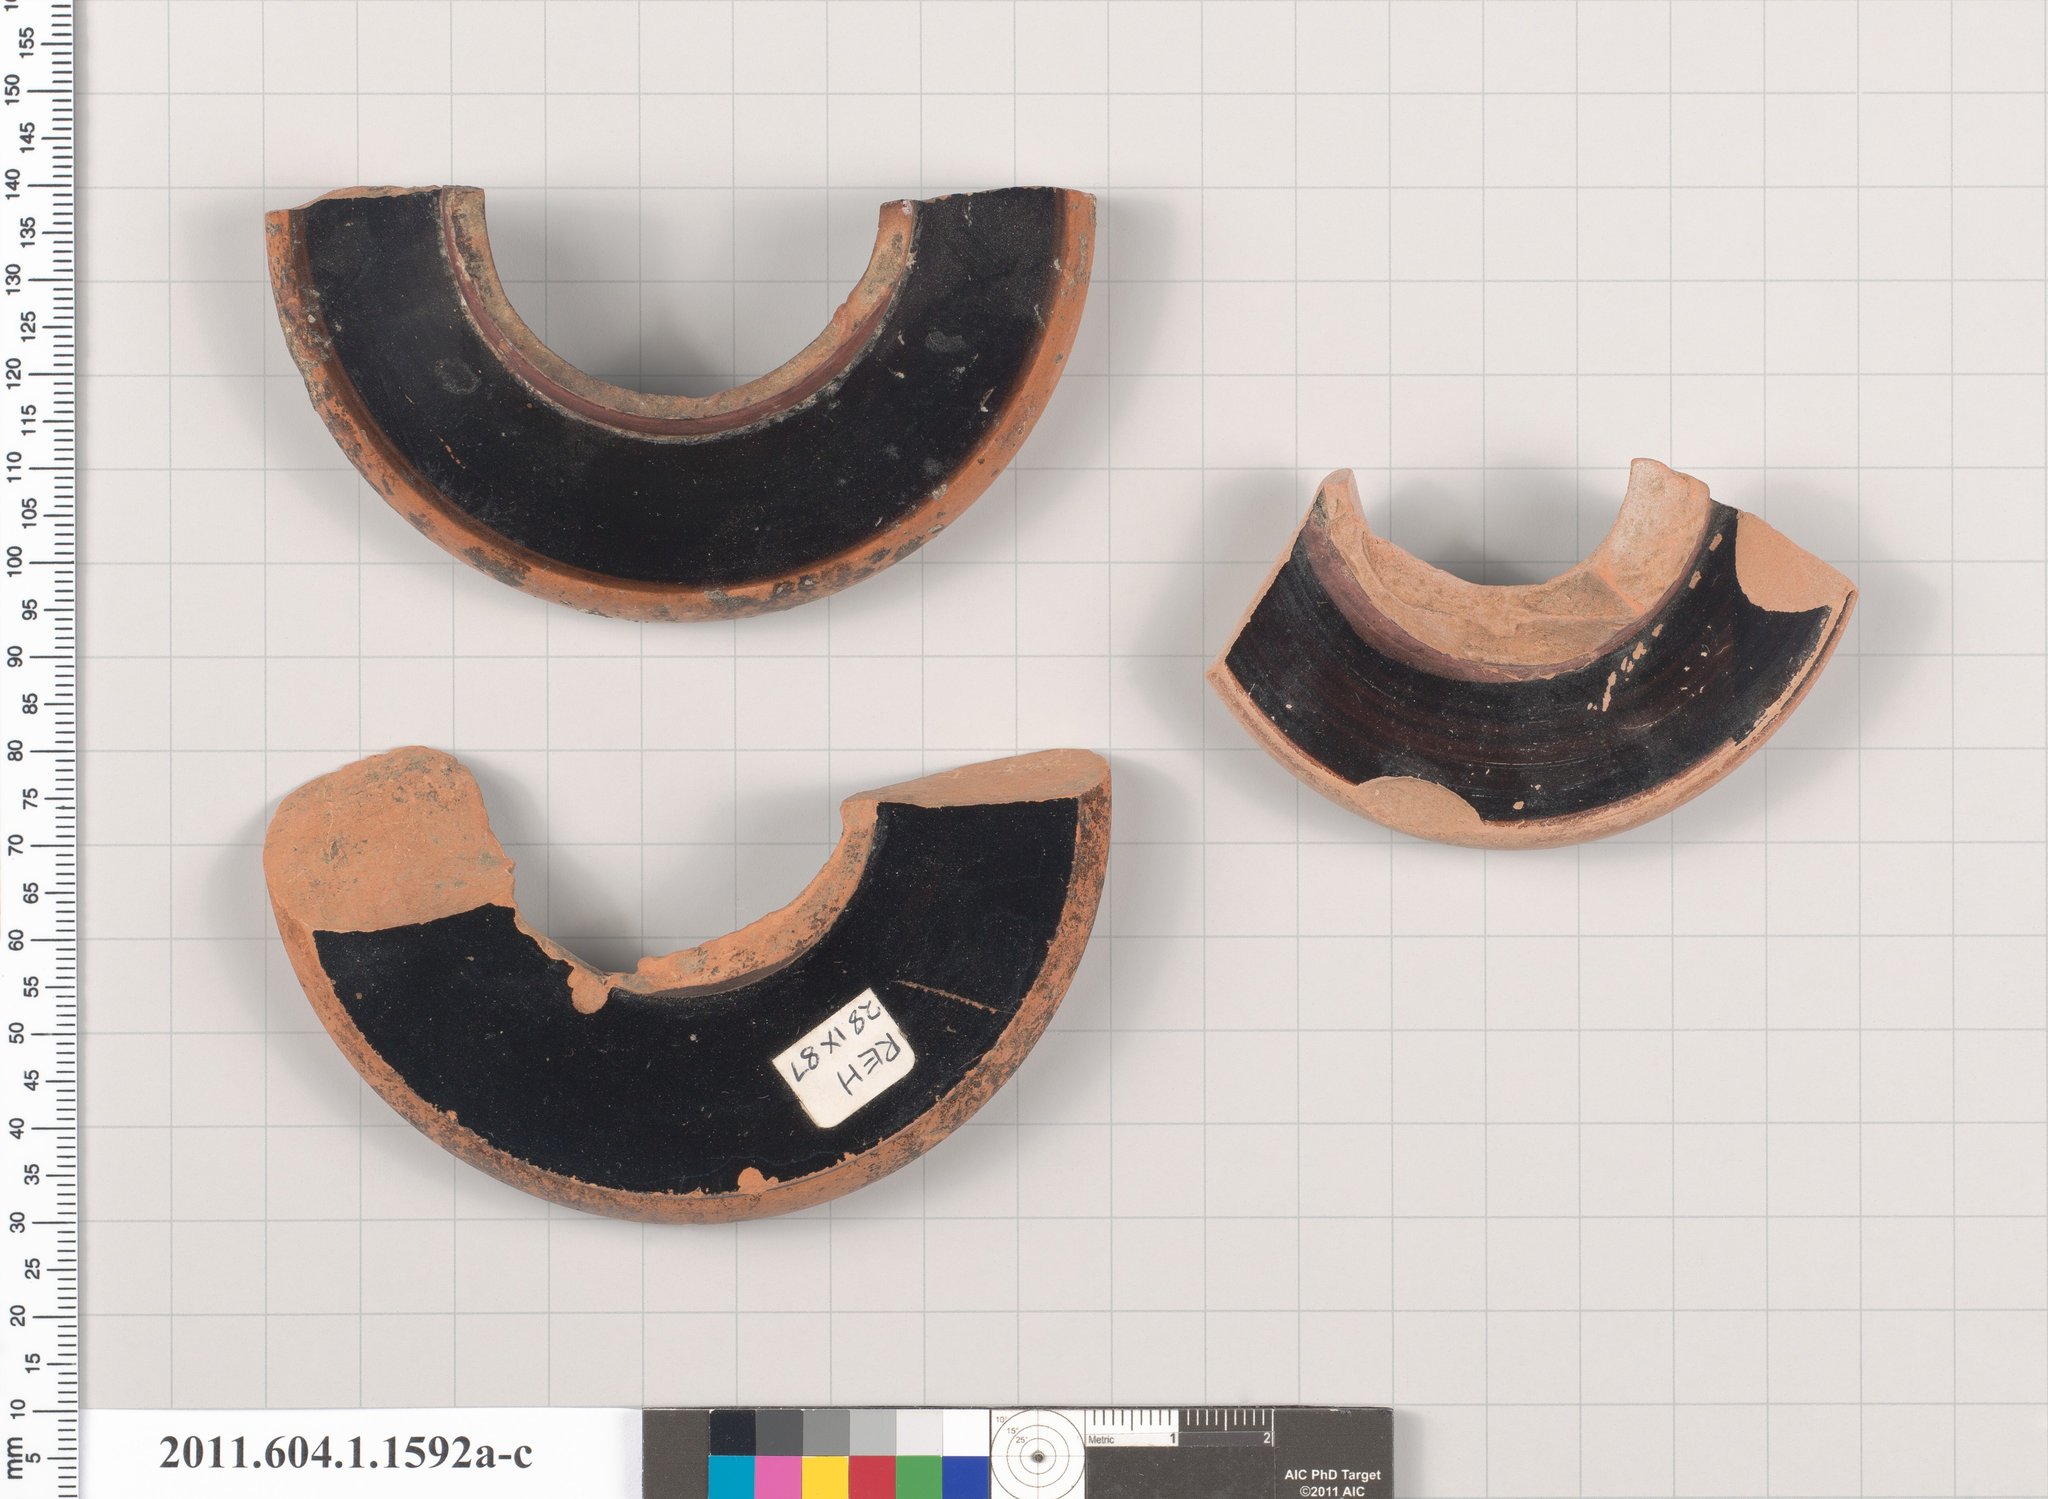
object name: kylix fragment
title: Terracotta fragments of kylikes (drinking cups)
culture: greek, attic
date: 500-401 BCE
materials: terracotta